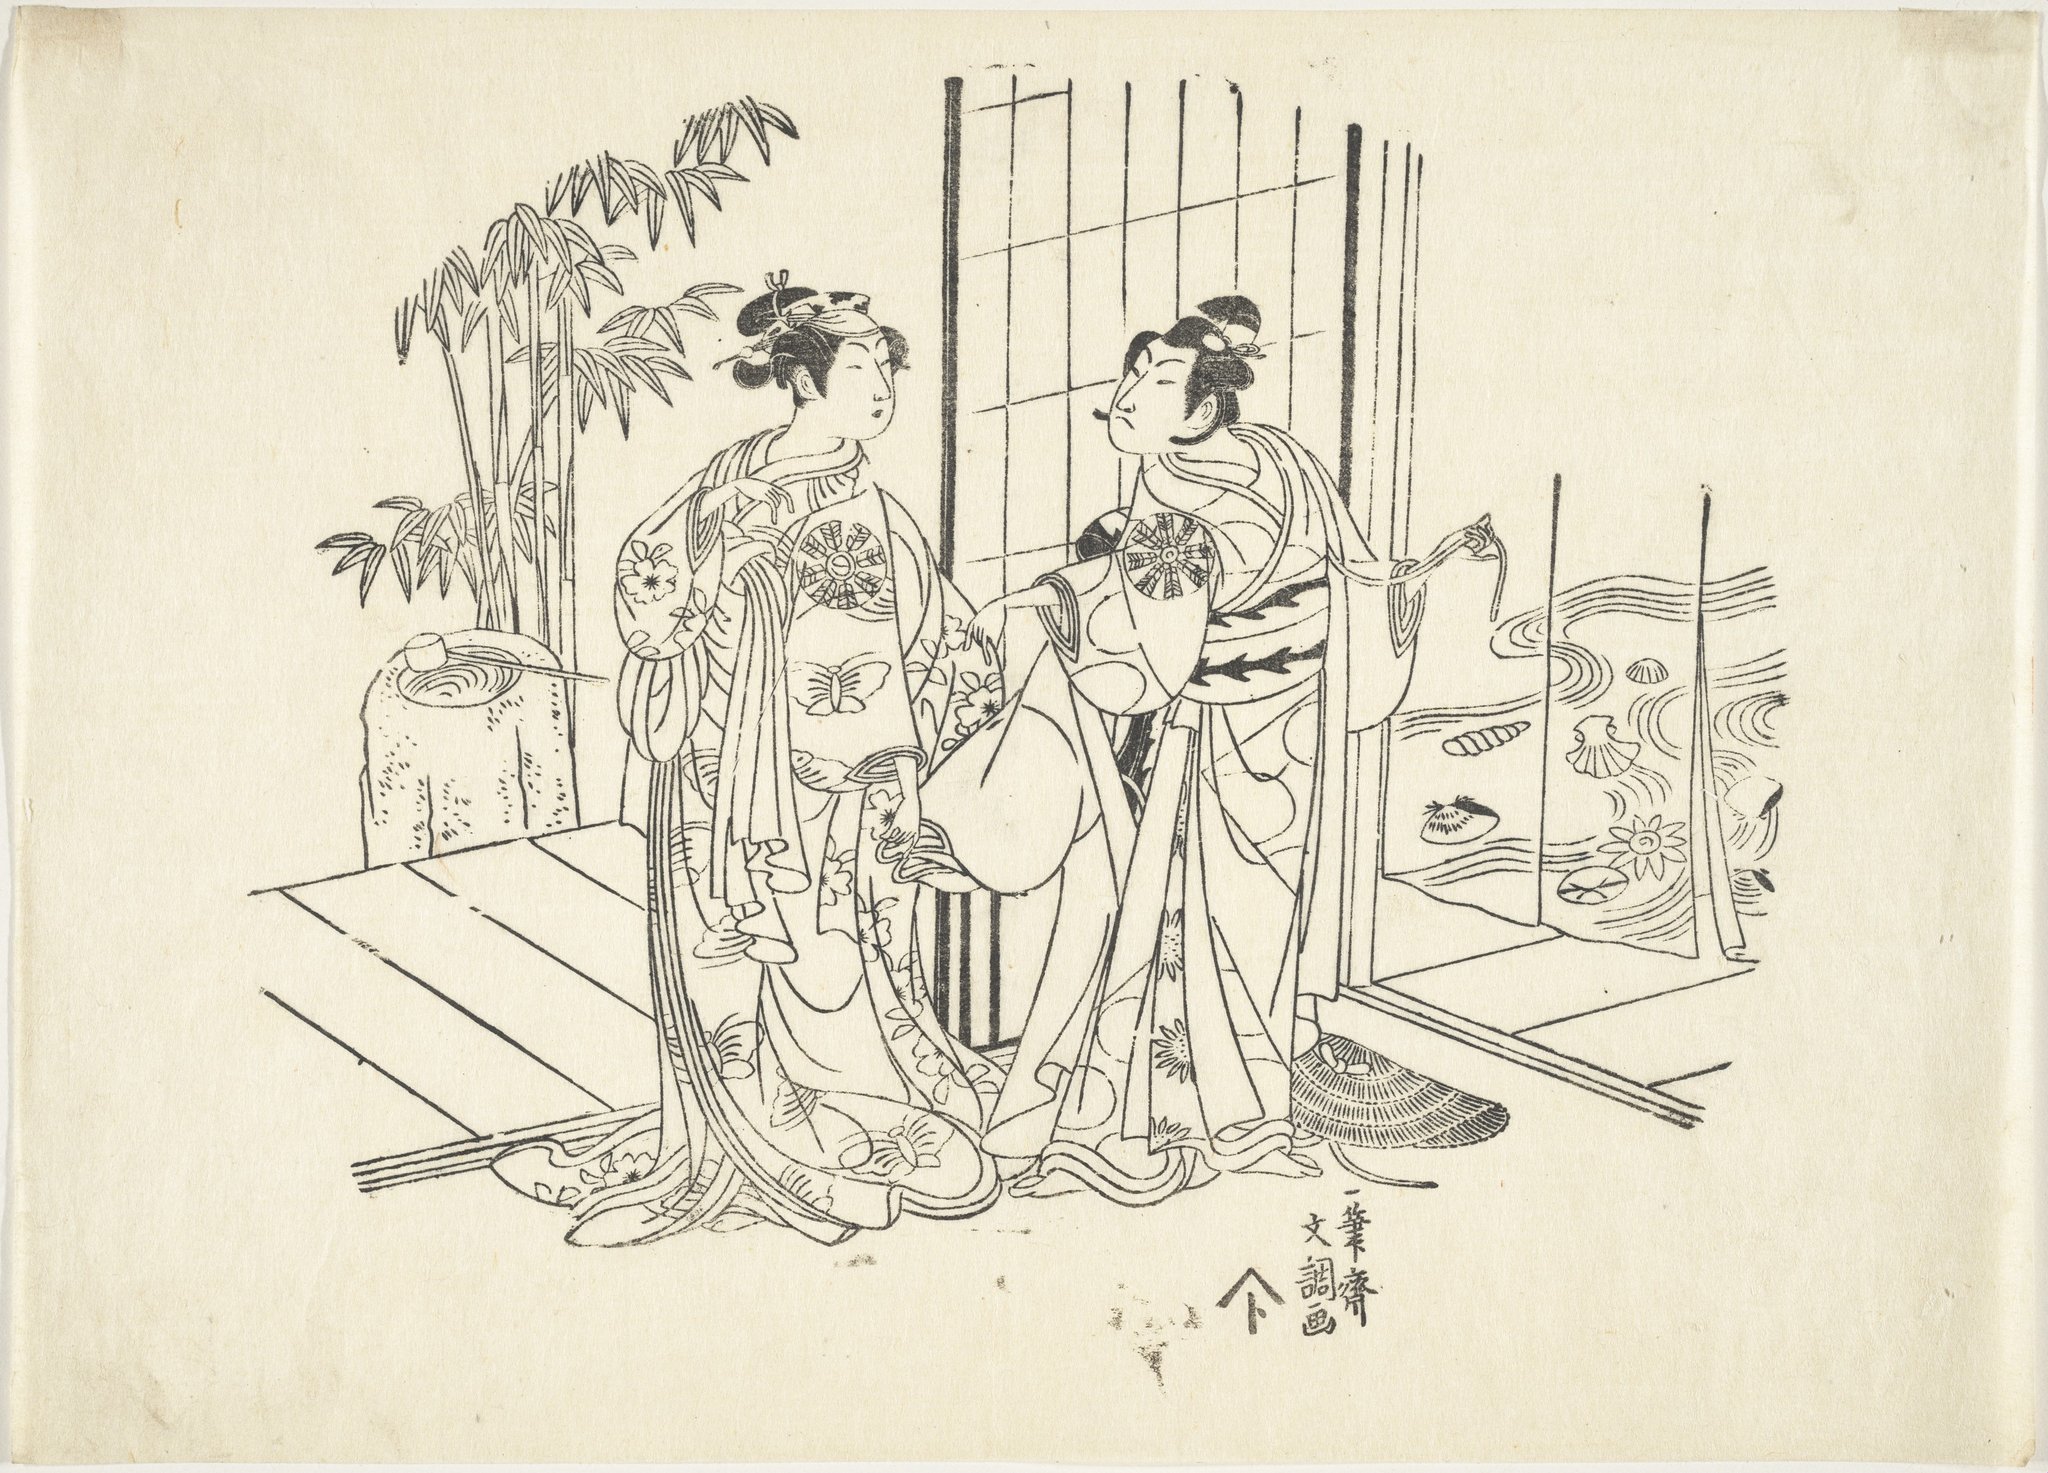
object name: design for a fan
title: The Actors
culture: japanese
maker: ippitsusai bunchō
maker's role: artist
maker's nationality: japanese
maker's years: 1765-1792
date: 1723-1792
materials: ink, paper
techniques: woodblock print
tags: human figures,plants,actors